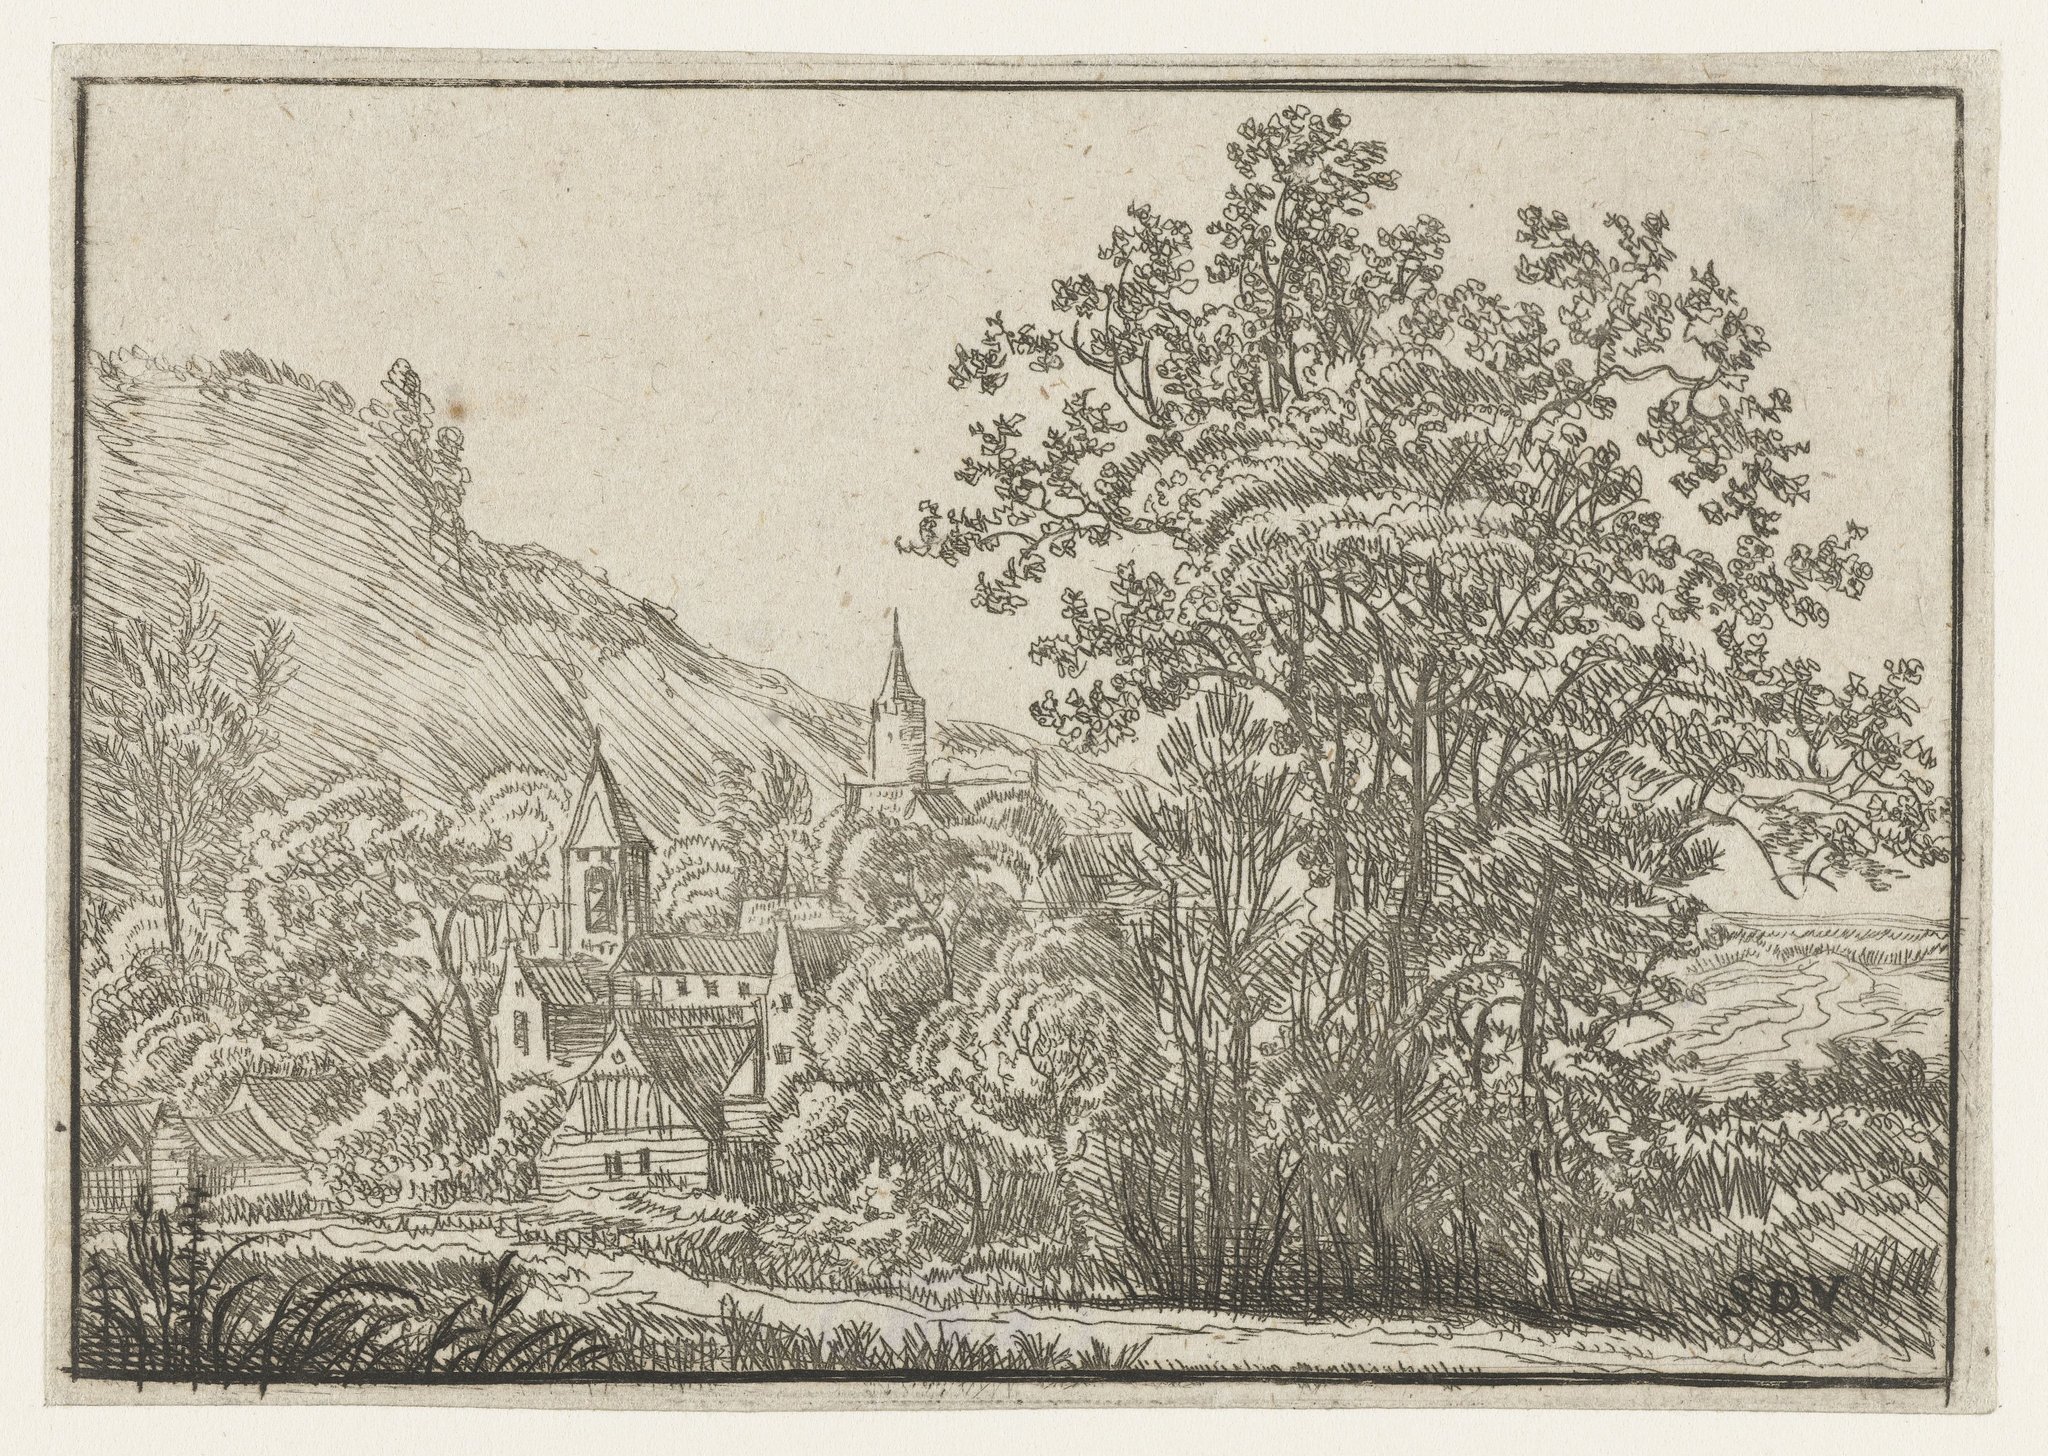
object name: print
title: Dorp met twee torens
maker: Anonymous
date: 1610-1703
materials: paper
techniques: engraving, etching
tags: village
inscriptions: collector's mark: Lugt 2228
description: Een dorp met twee gebouwen met hoge torens aan de voet van een heuvel.